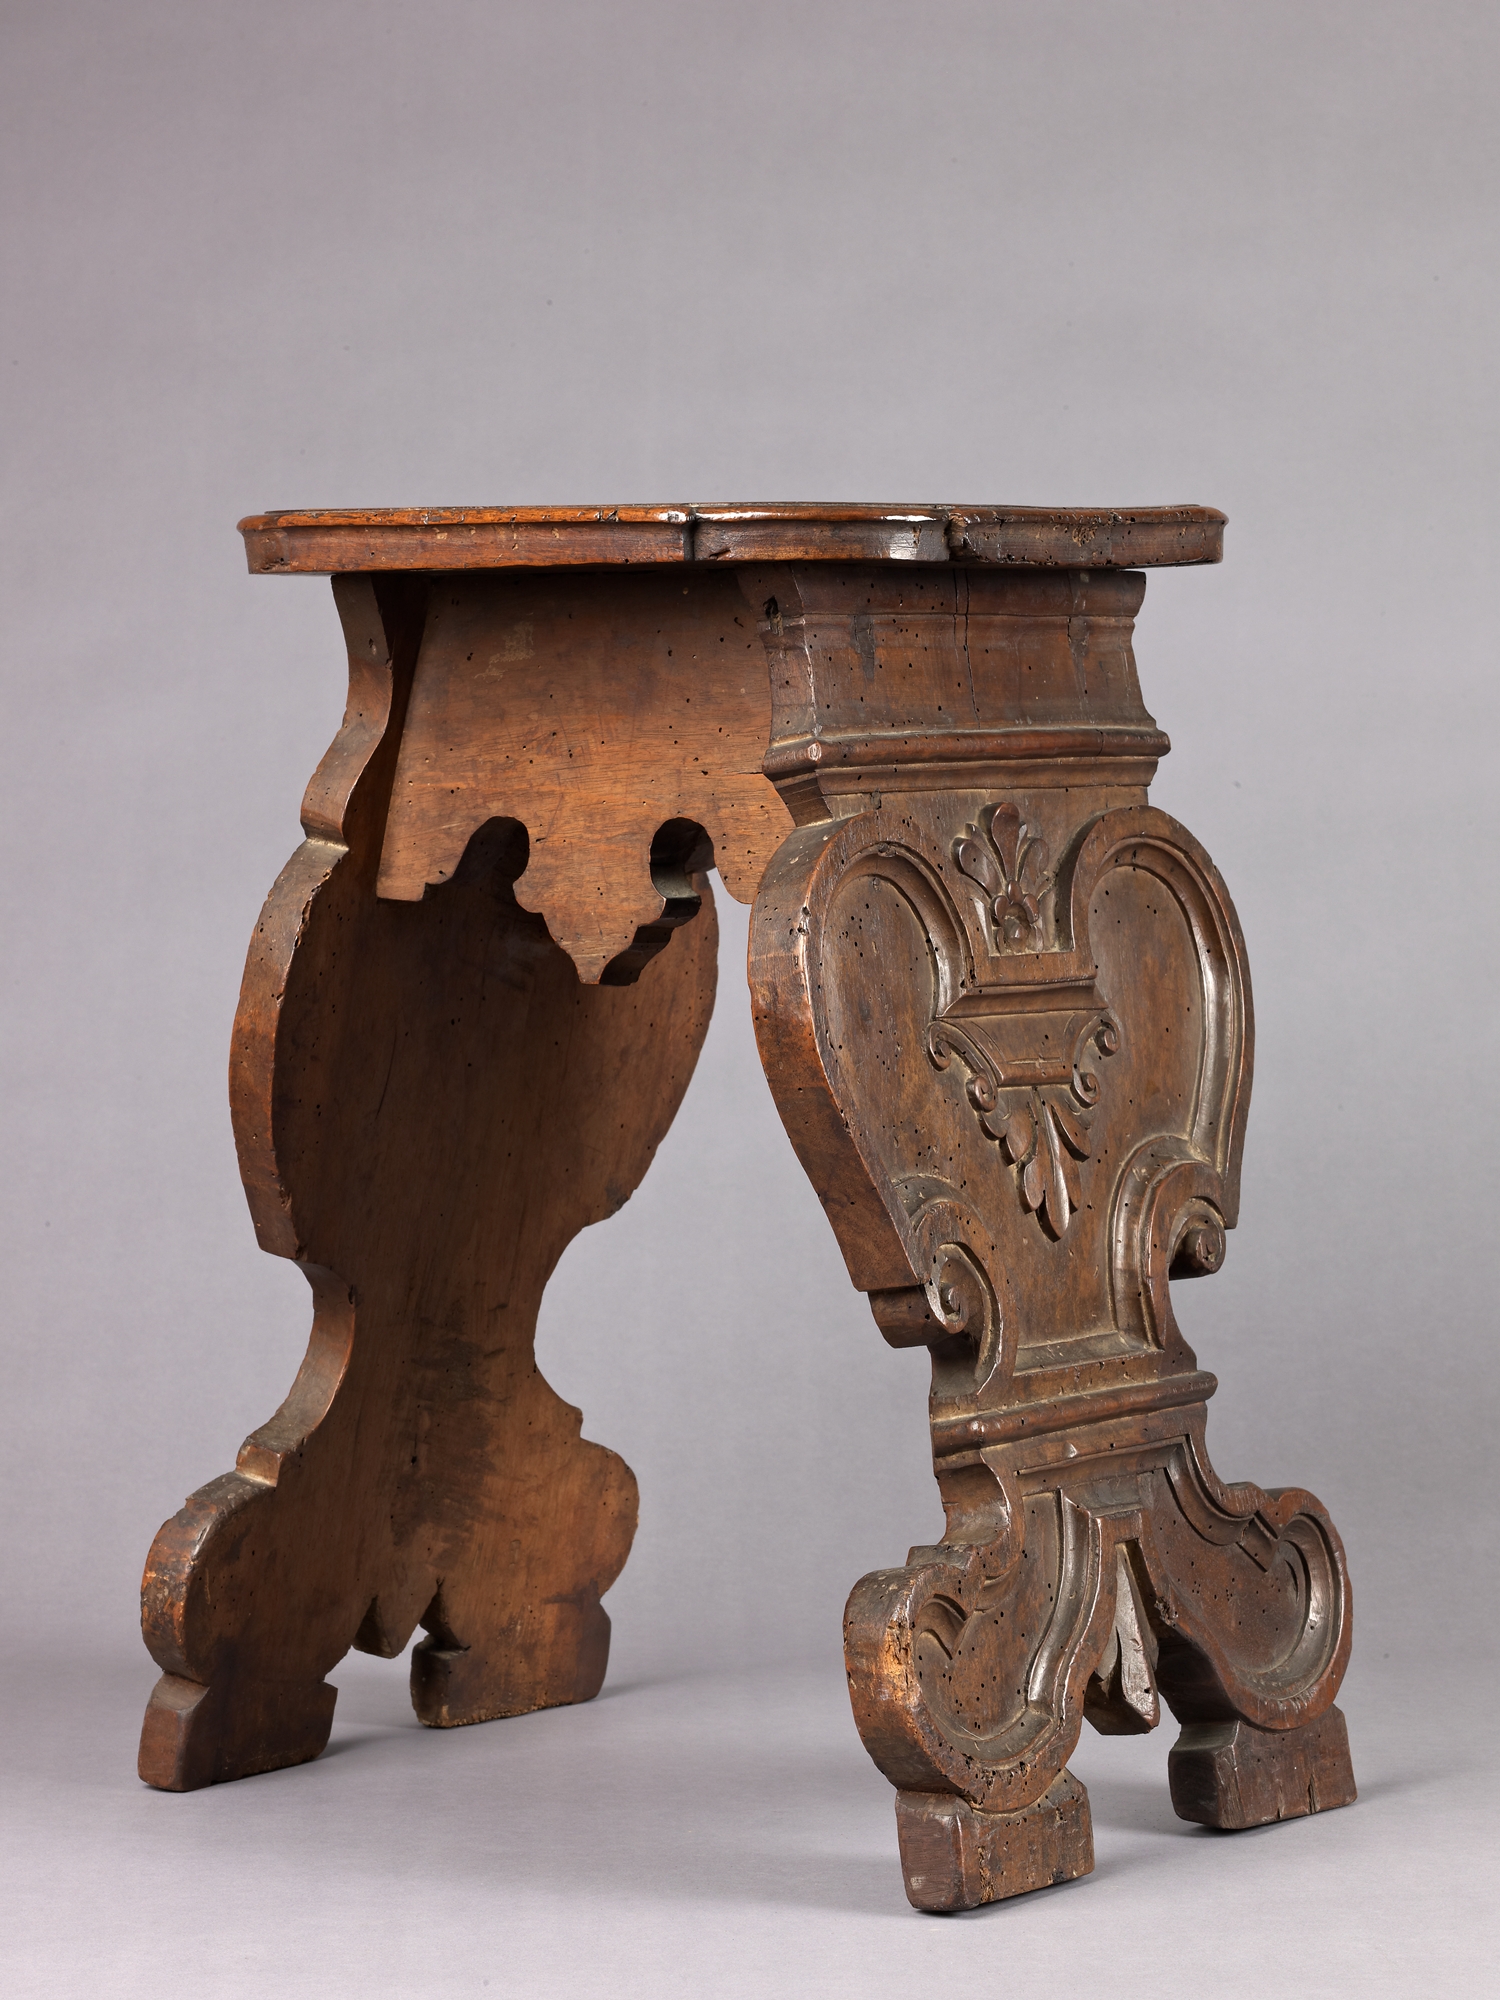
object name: stool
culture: italian, tuscany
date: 1501-1600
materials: wood